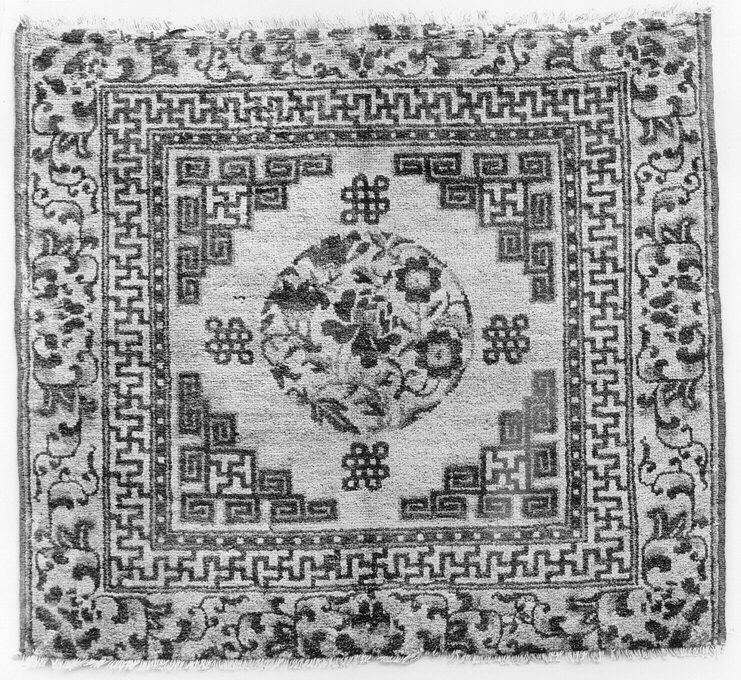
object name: cushion cover or kneeling mat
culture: chinese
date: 1701-1900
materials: cotton, wool